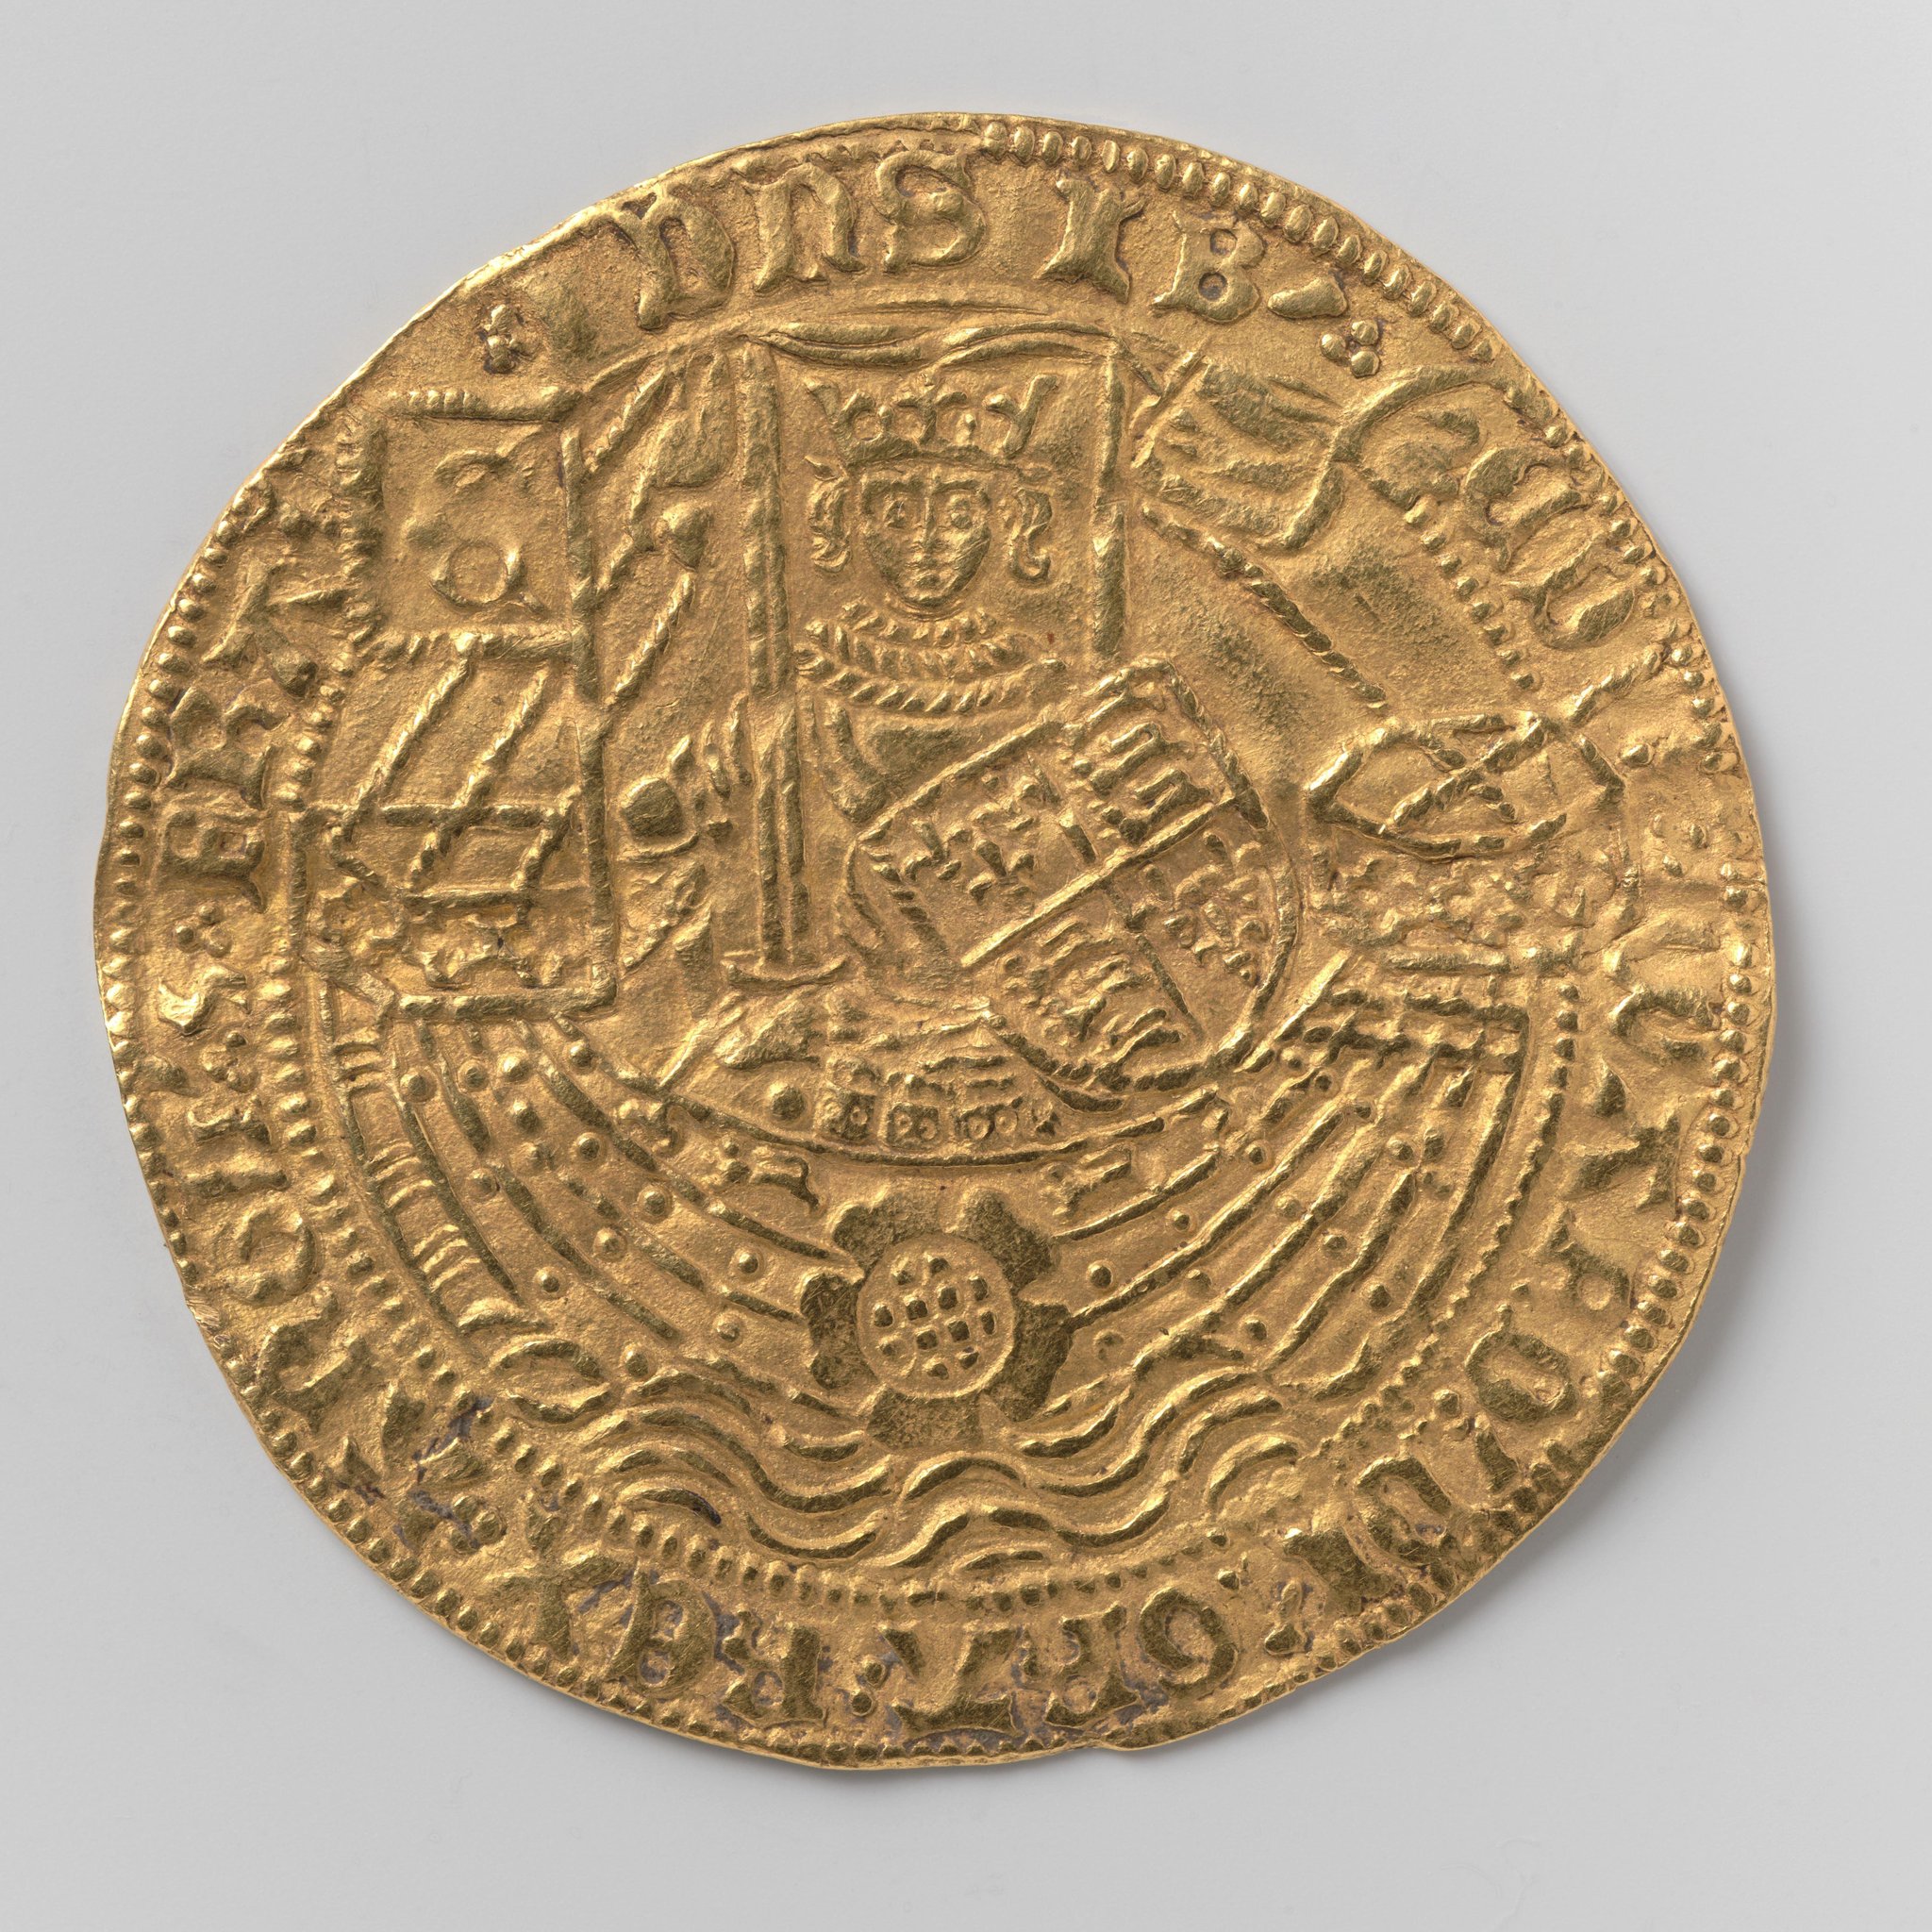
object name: rozenobel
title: Continentale 16e eeuwse imitatie van Engelse rozenobel van Edward IV, 1461-1470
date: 1575-1600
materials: gold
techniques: striking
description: Gouden munt. Voorzijde: gekroonde staande vorst met in rechterhand zwaard en in linkerhand wapenschild, staande in een schip. Midden op scheepswand een roos en op achtersteven staande vlag, waarin letter E. Keerzijde: binnen dubbellijnige veelpas kort rijk versierd kruis met in het centrum roos waauit zonnestralen en in de hoeken gekroonde luipaarden.